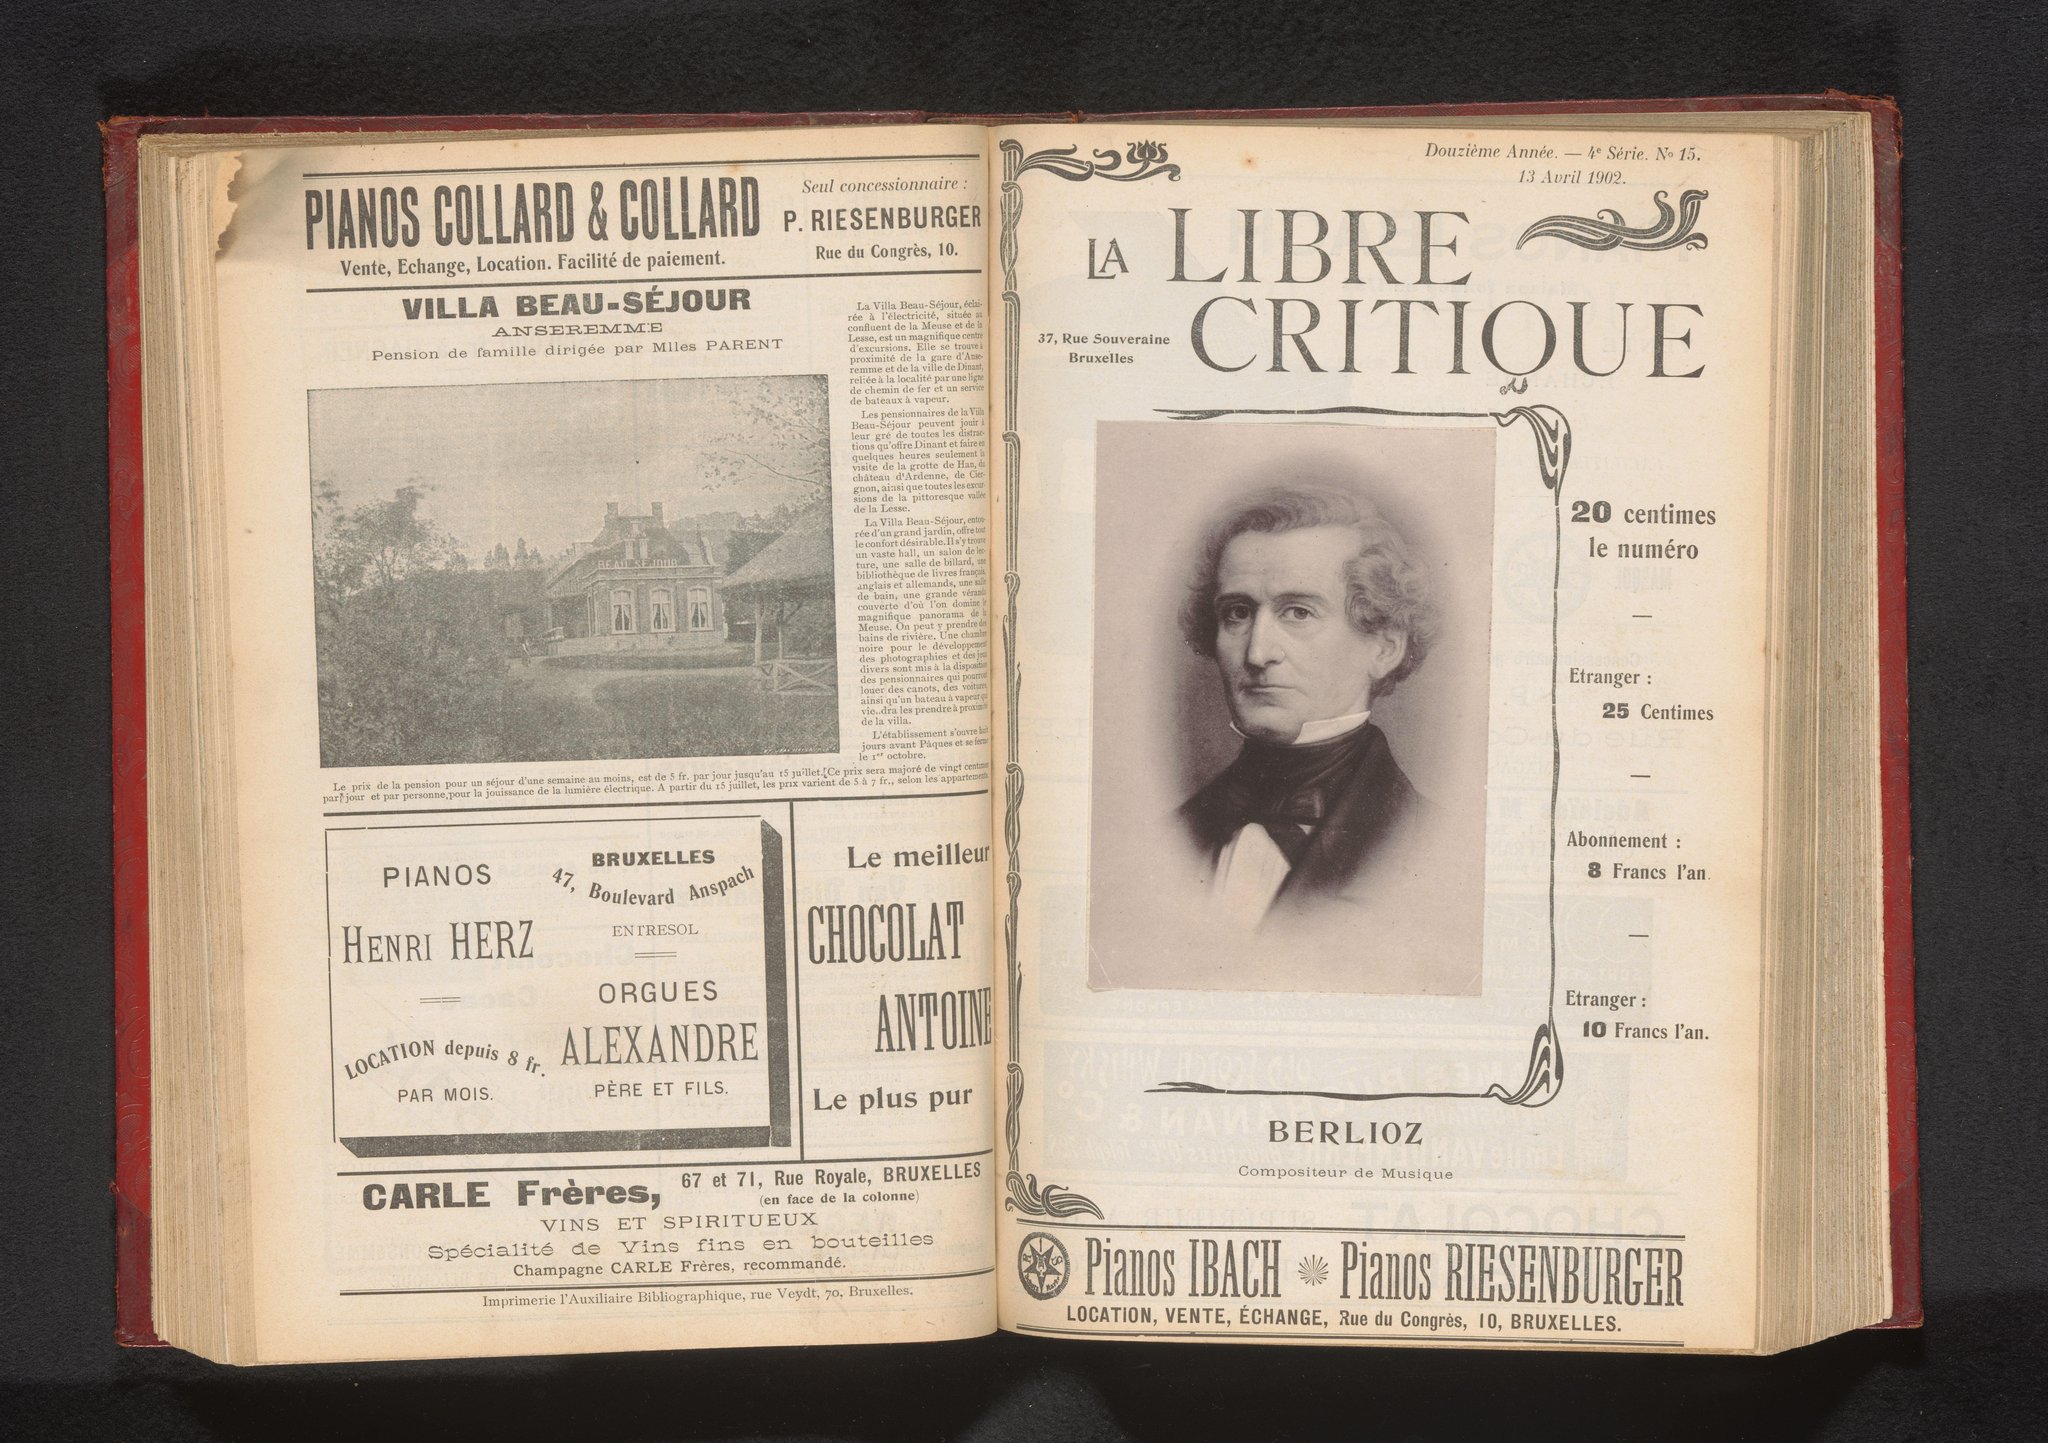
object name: photomechanical print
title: Berlioz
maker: Anonymous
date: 1897-1902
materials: paper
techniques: photograph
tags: paris, hector berlioz, portrait of composer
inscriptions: inscription: ‘Compositeur de Musique’